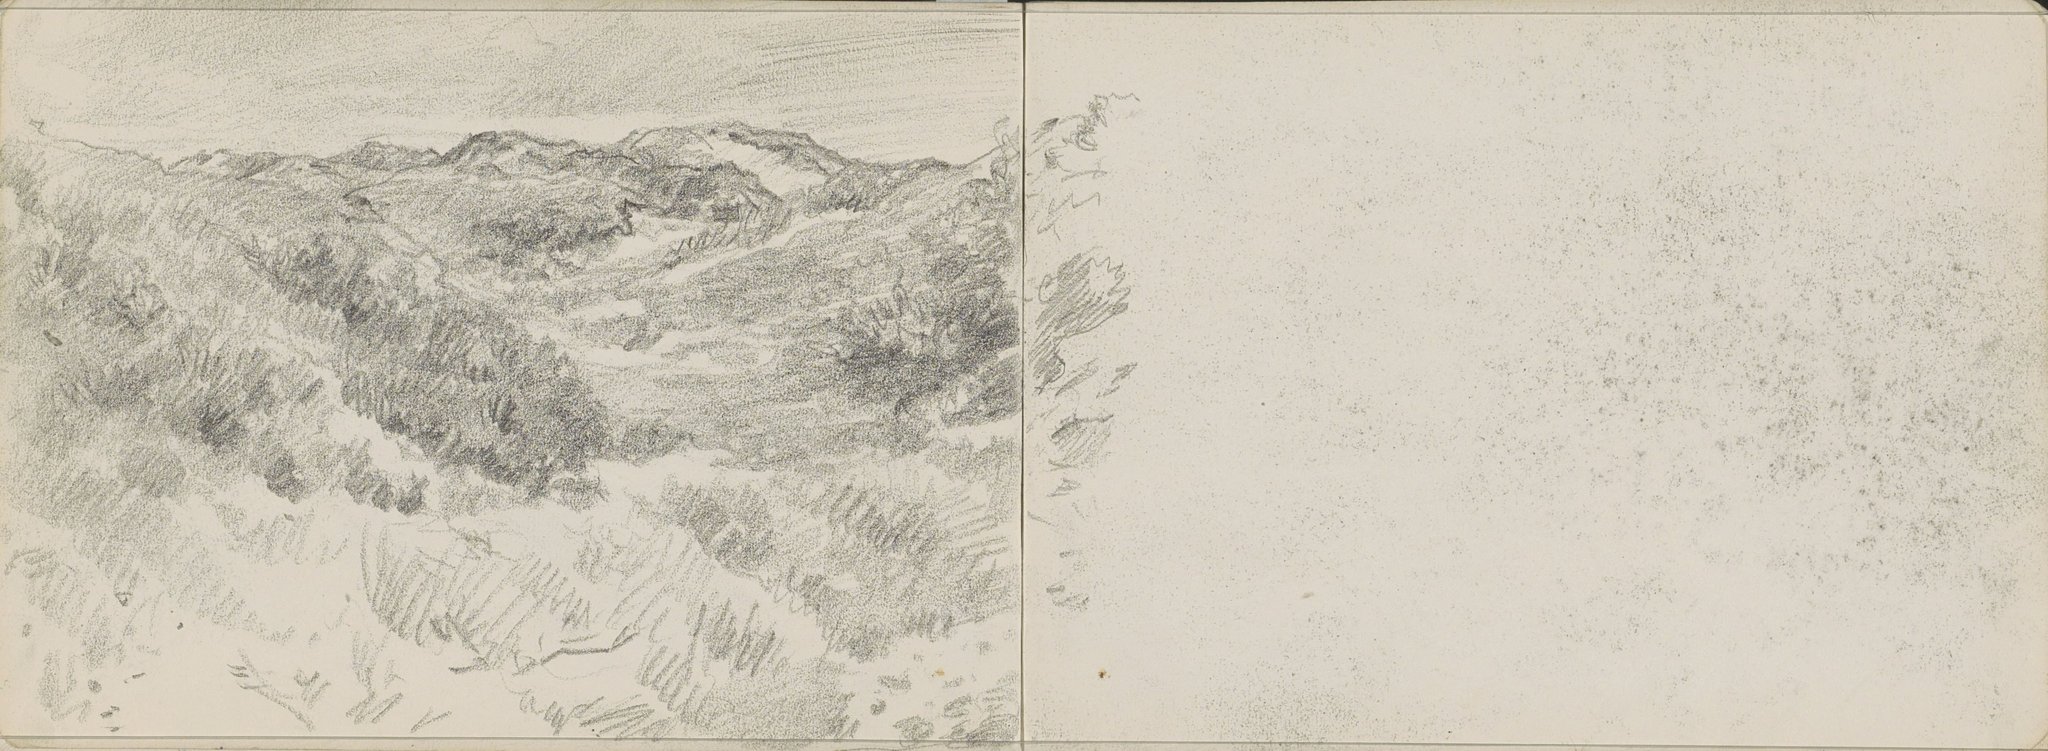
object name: sketchbook leaf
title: Duinlandschap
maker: johan antonie de jonge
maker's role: draughtsman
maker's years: 1864-1927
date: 1881-1927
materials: chalk, paper, pencil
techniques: stumping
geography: south holland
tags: dunes (sea not visible); in the dunes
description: Duinlandschap. Blad 11 verso uit een schetsboek met 28 bladen.